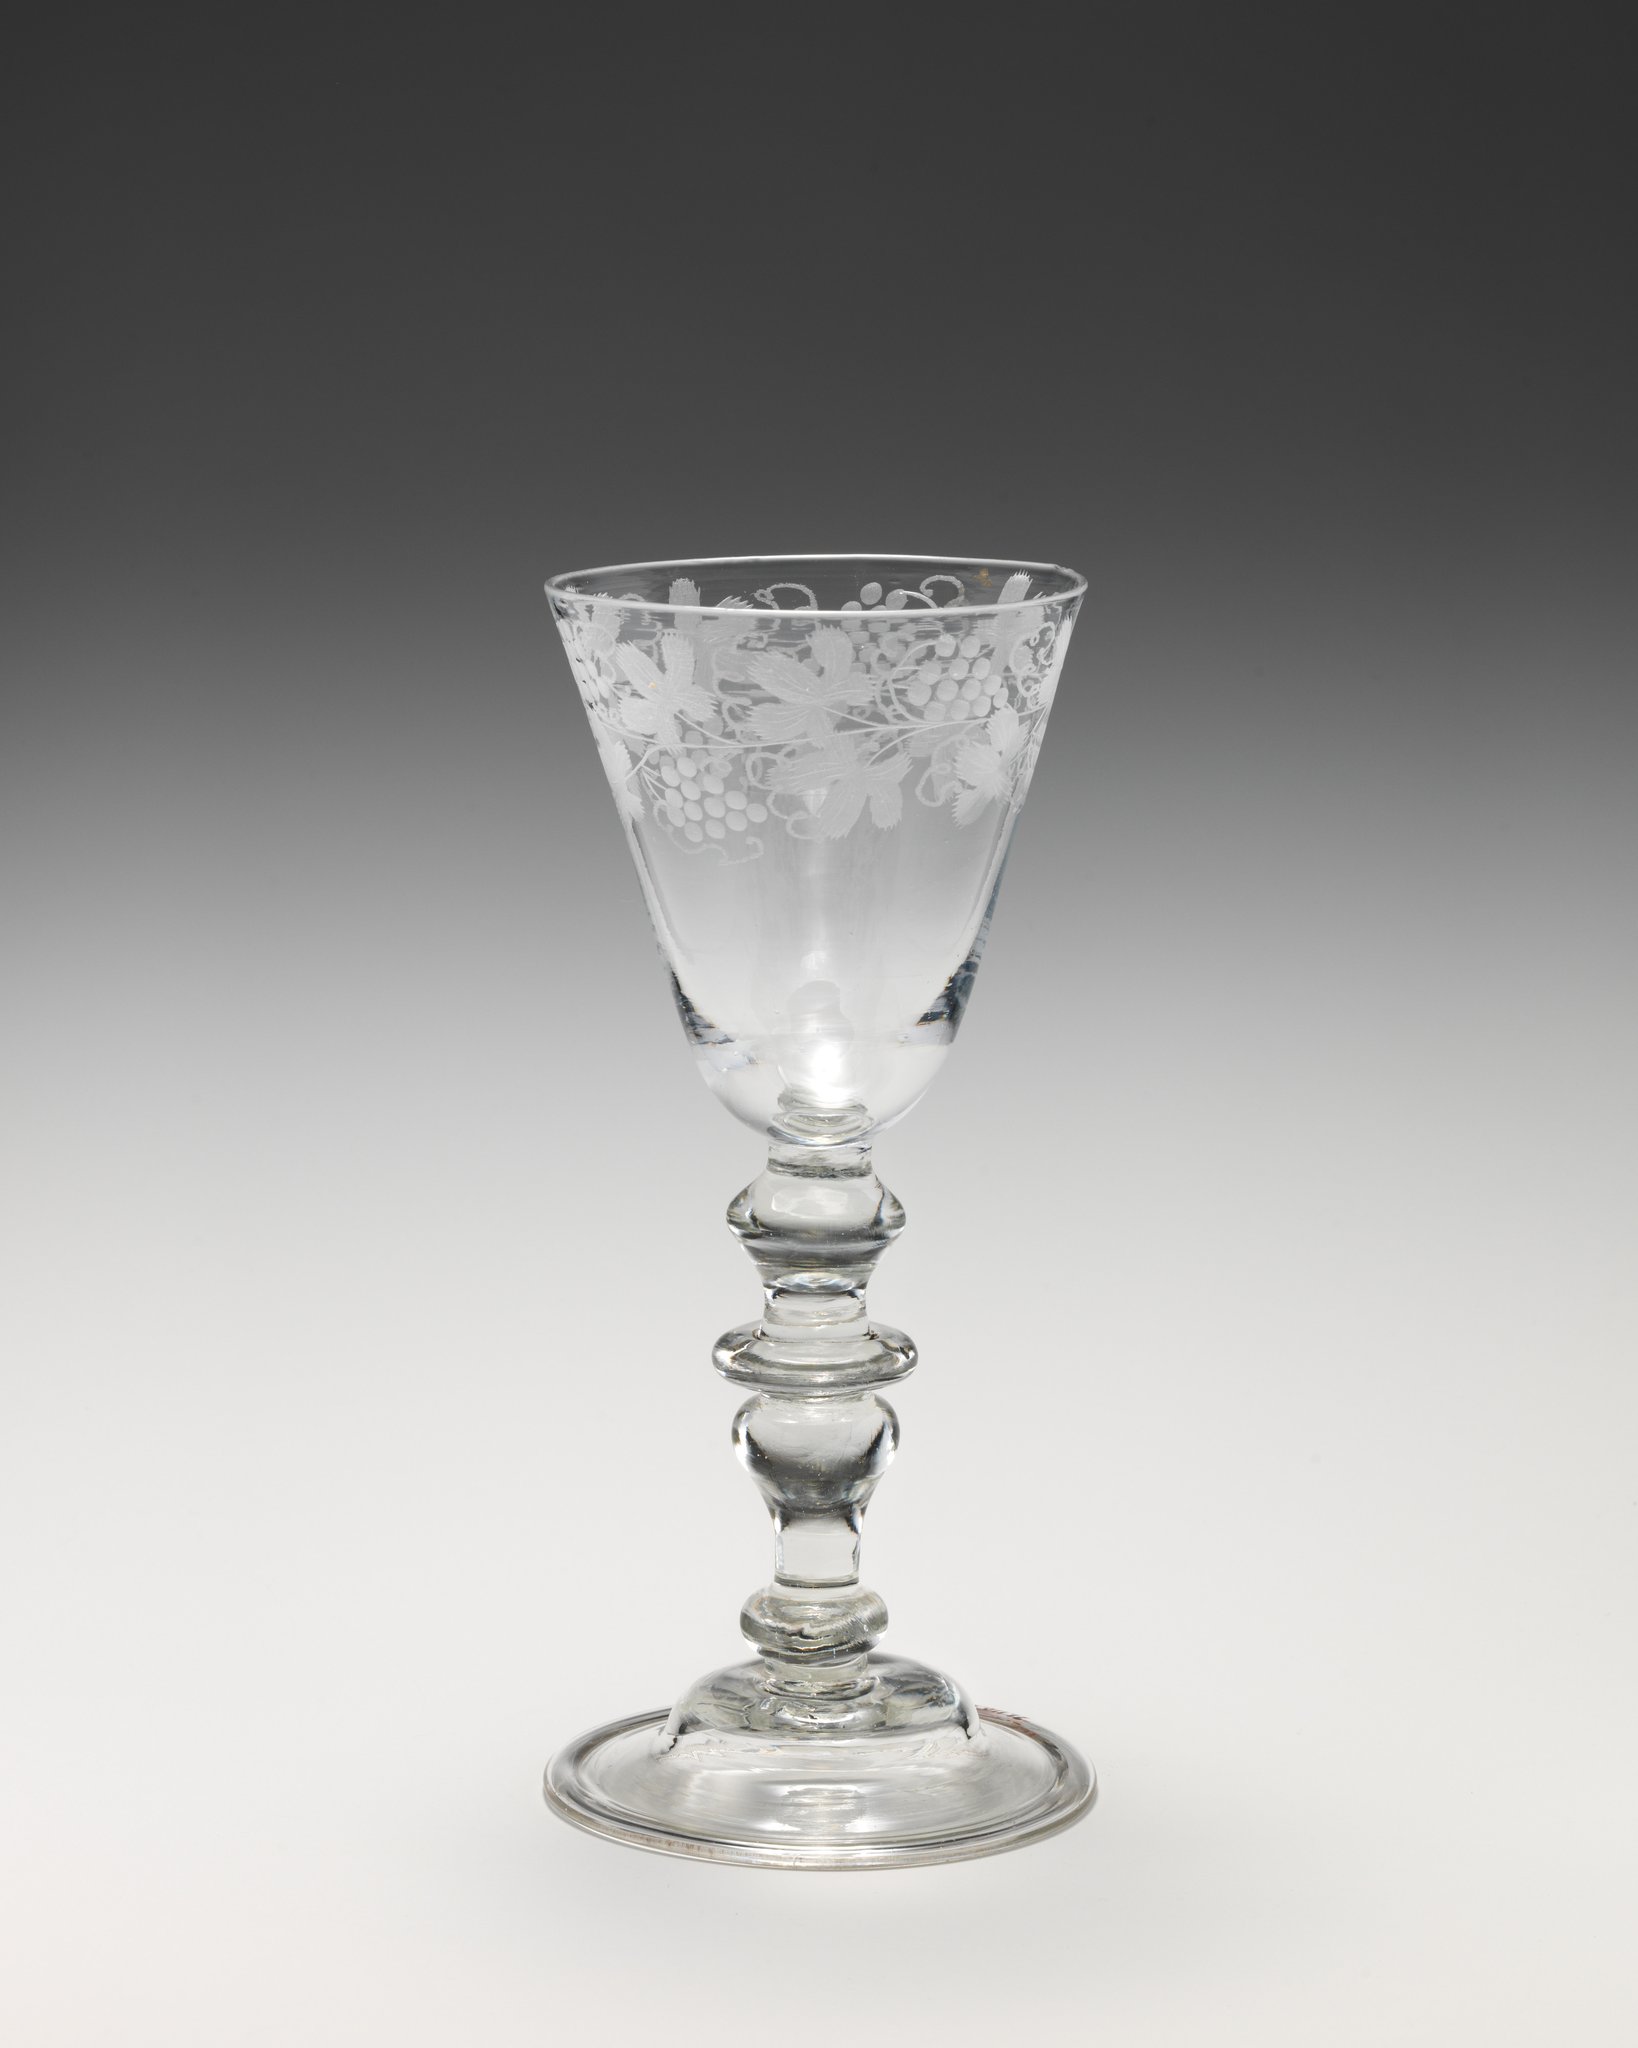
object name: wineglass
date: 1700-1750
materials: glass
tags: grapes